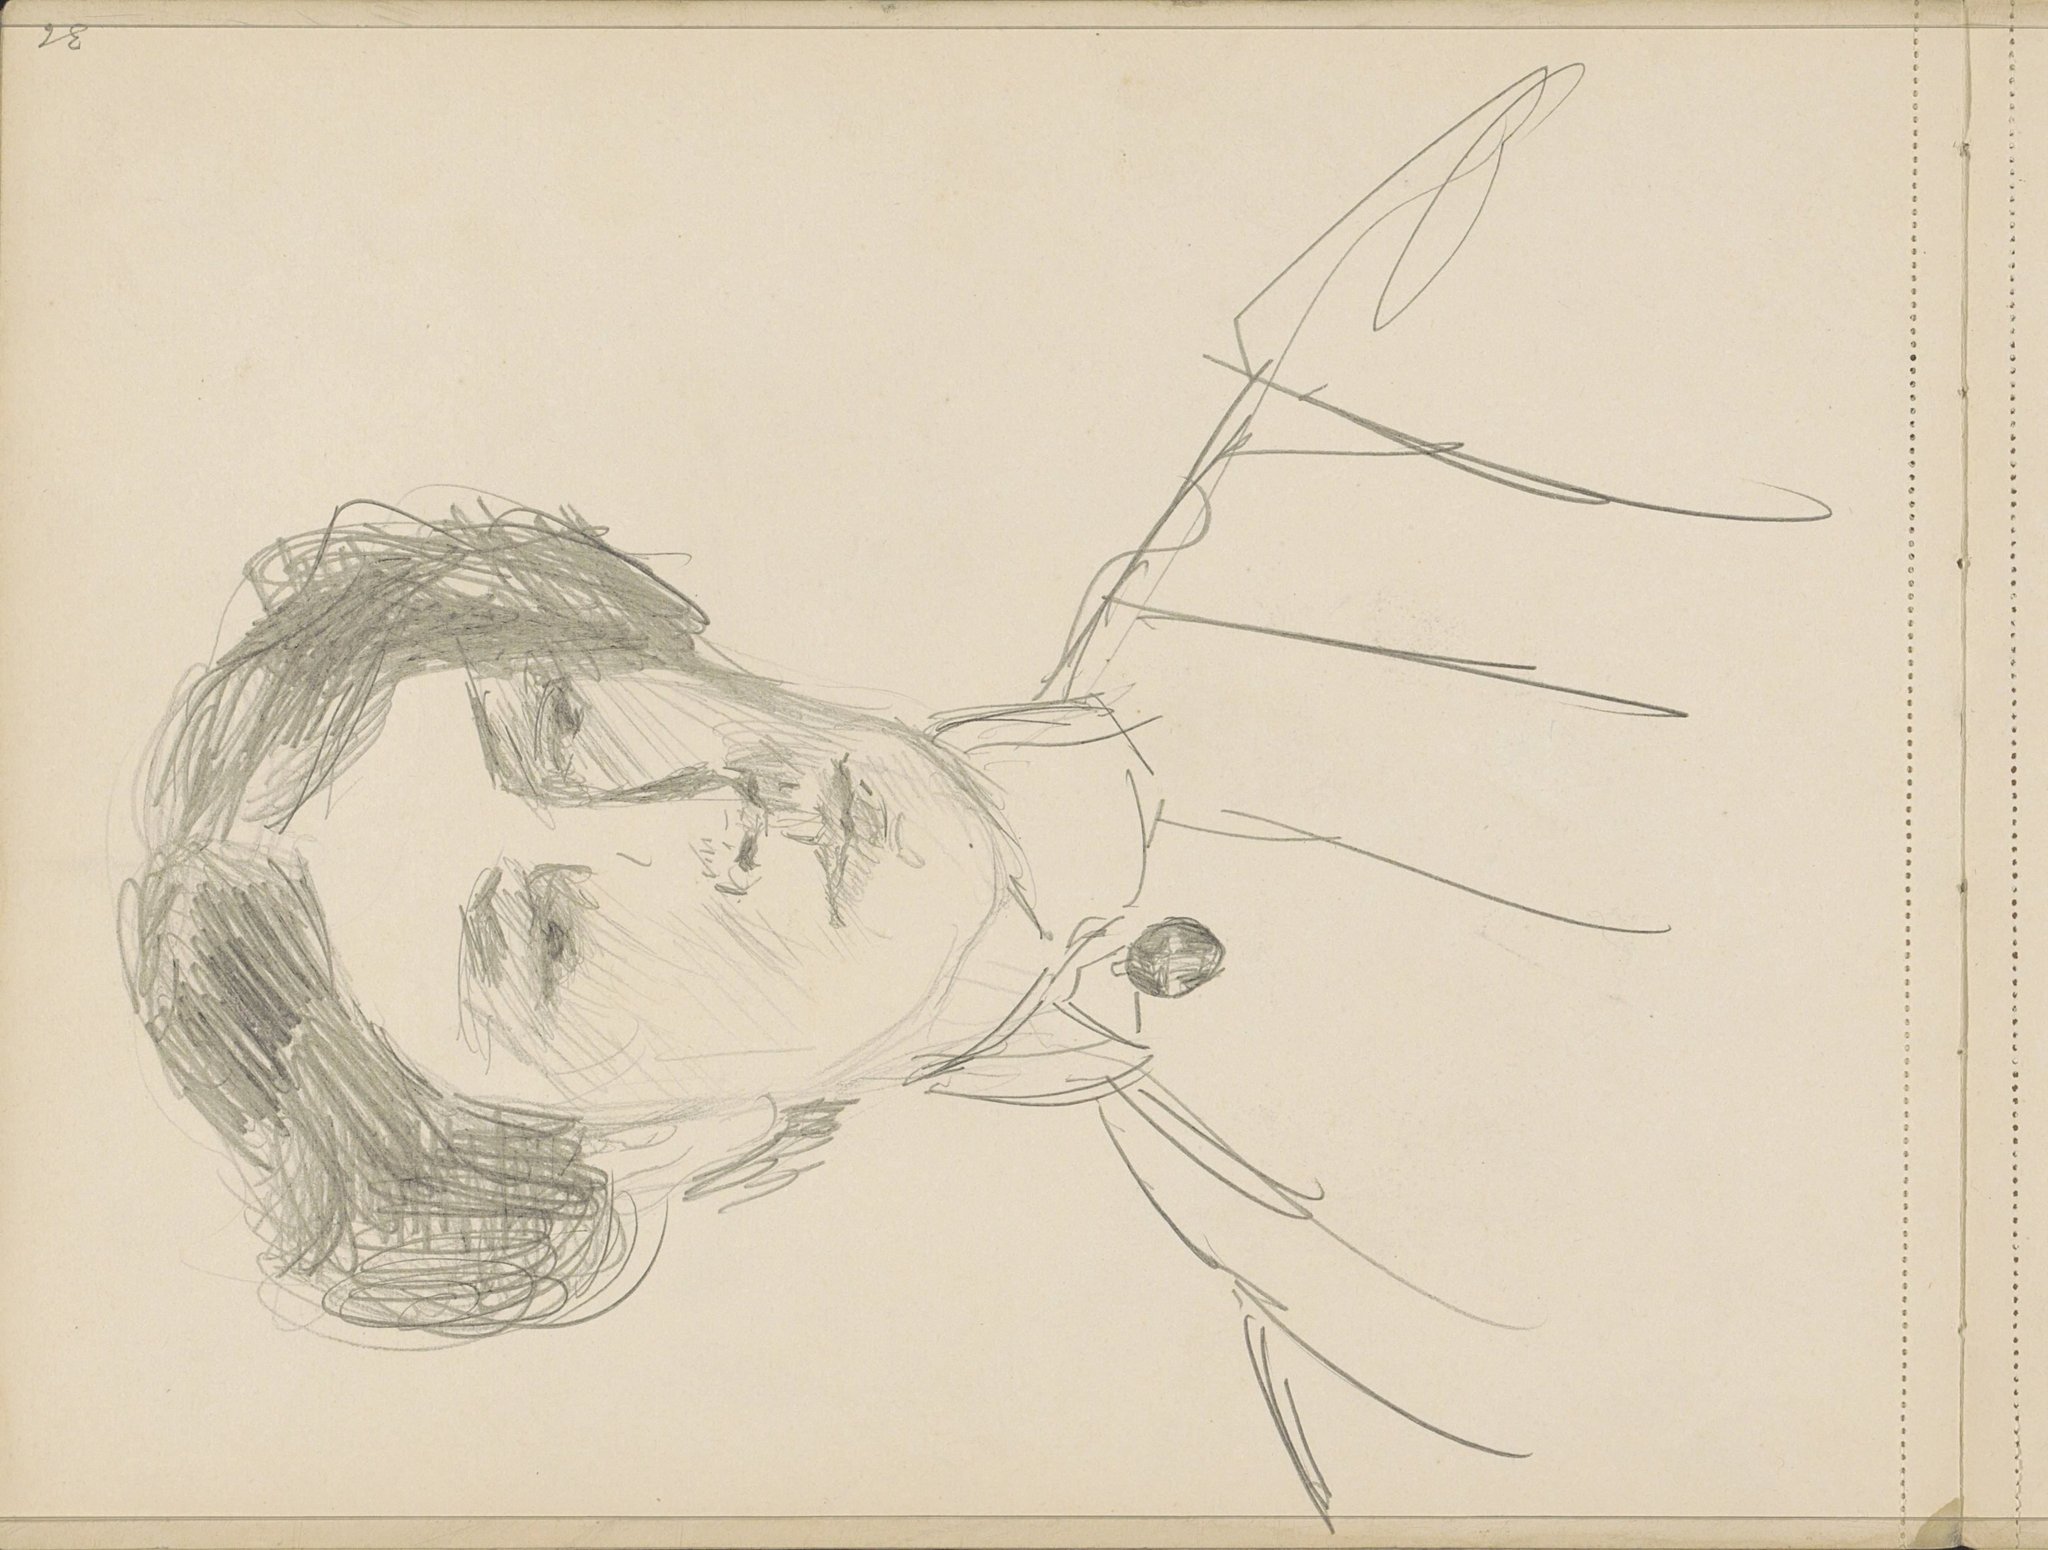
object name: sketchbook leaf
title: Portret van een onbekende vrouw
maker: isaac israels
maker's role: draughtsman, painter, print maker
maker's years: 1865-1934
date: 1875-1934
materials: paper, pencil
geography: the hague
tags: adult woman, anonymous historical person portrayed - bb - woman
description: Blad 6 recto uit schetsboek XXIII met 20 bladen.